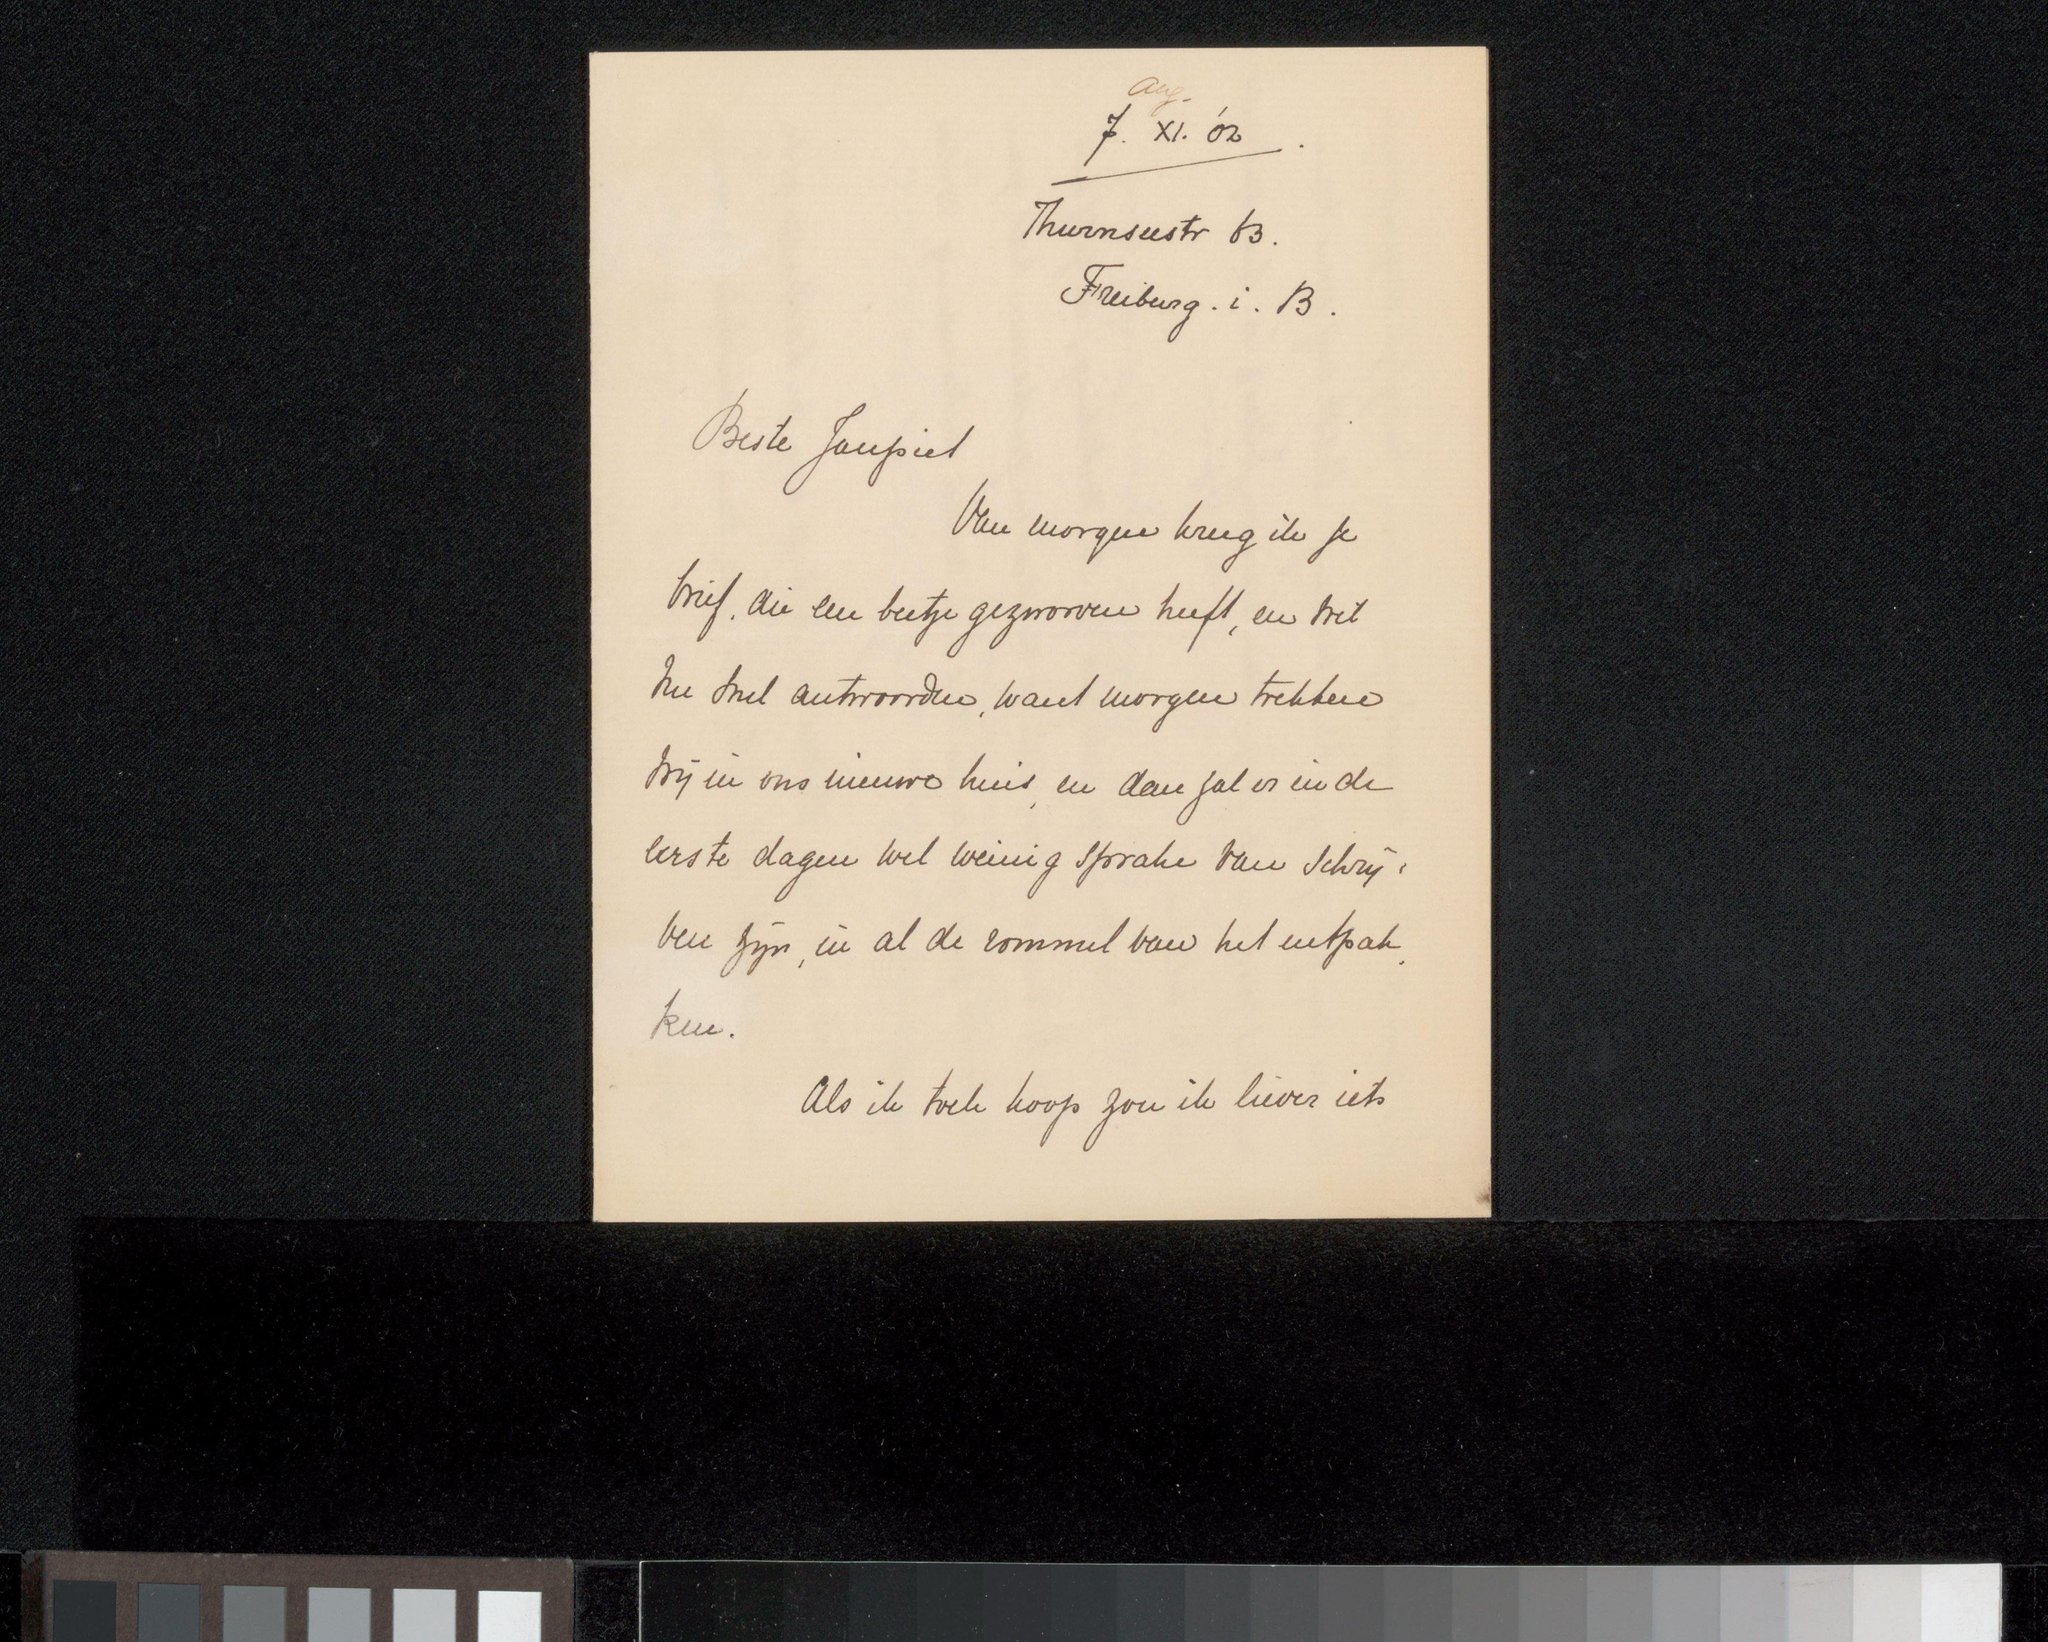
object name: letter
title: Brief aan Jan Veth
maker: andré jolles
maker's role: journalist, kunsthistoricus, letterkundige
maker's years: 1874-1946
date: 1902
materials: ink, paper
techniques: pen, writing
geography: freiburg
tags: dordrecht, painter, print maker, draughtsman, designer, jan veth, karel petrus cornelis de bazel, artist, anna dorothea dirks, literature ~ arts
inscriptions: watermark, collector's mark: ‘RPK’